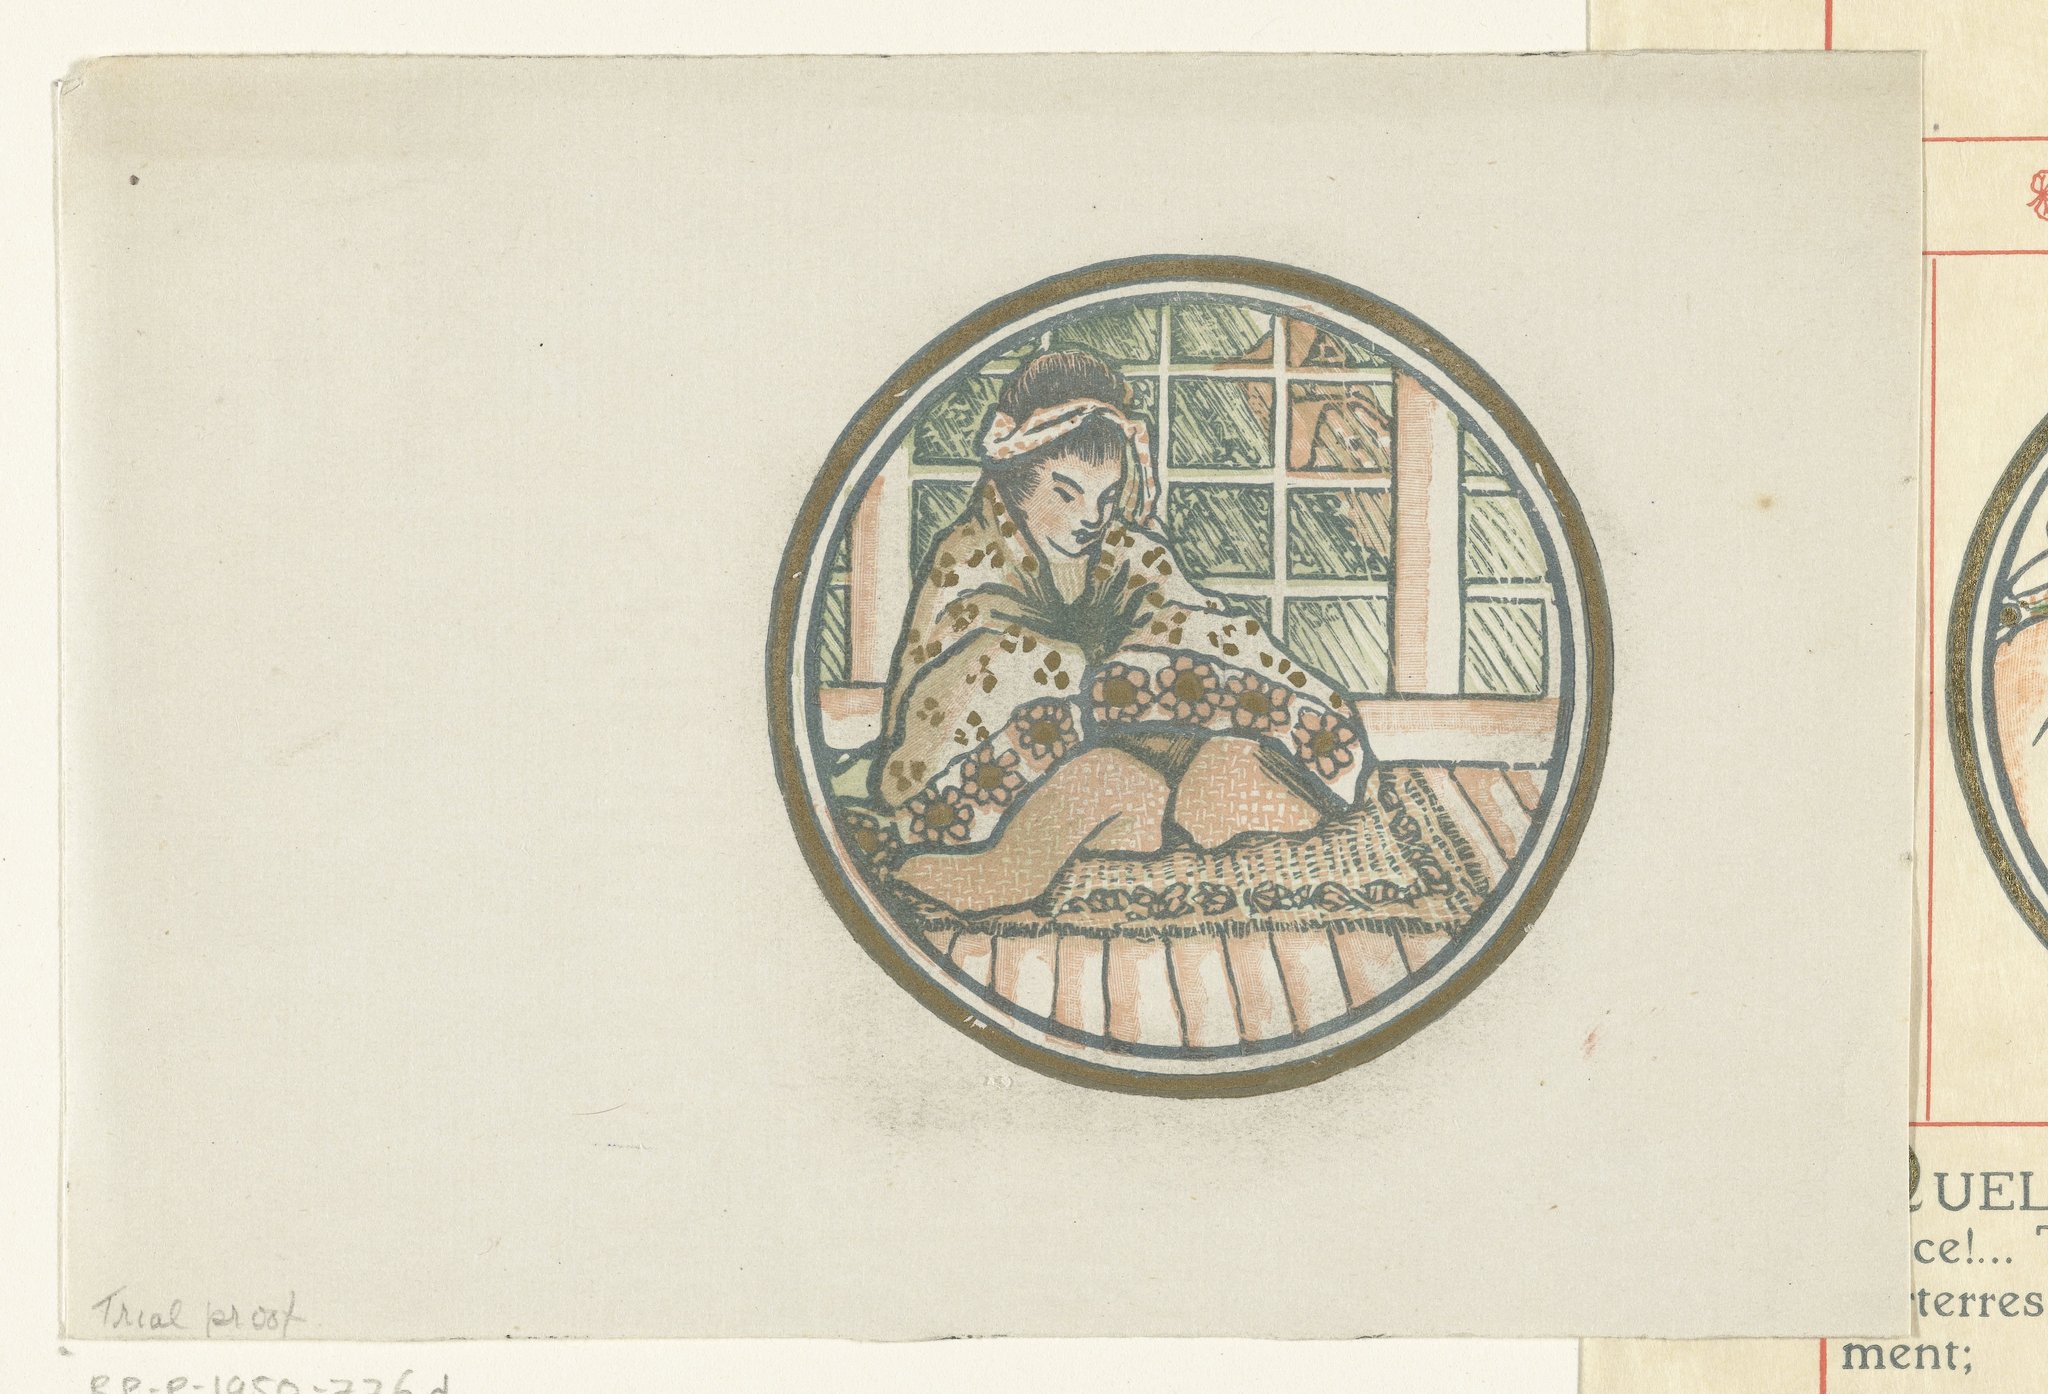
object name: print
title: Zittende Japanse vrouw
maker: lucien pissarro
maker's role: painter, print maker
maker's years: 1863-1944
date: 1911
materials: paper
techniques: printing, engraving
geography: england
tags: japanese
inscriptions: collector's mark: Lugt 2228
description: Proefdruk voor een boekillutratie voor: Judith Gautier, Poems Tirés du Livre de jade, uitgegeven bij Eragny Press (Lucien en Esther Pissarro), Hammersmith 1911 K.Botke